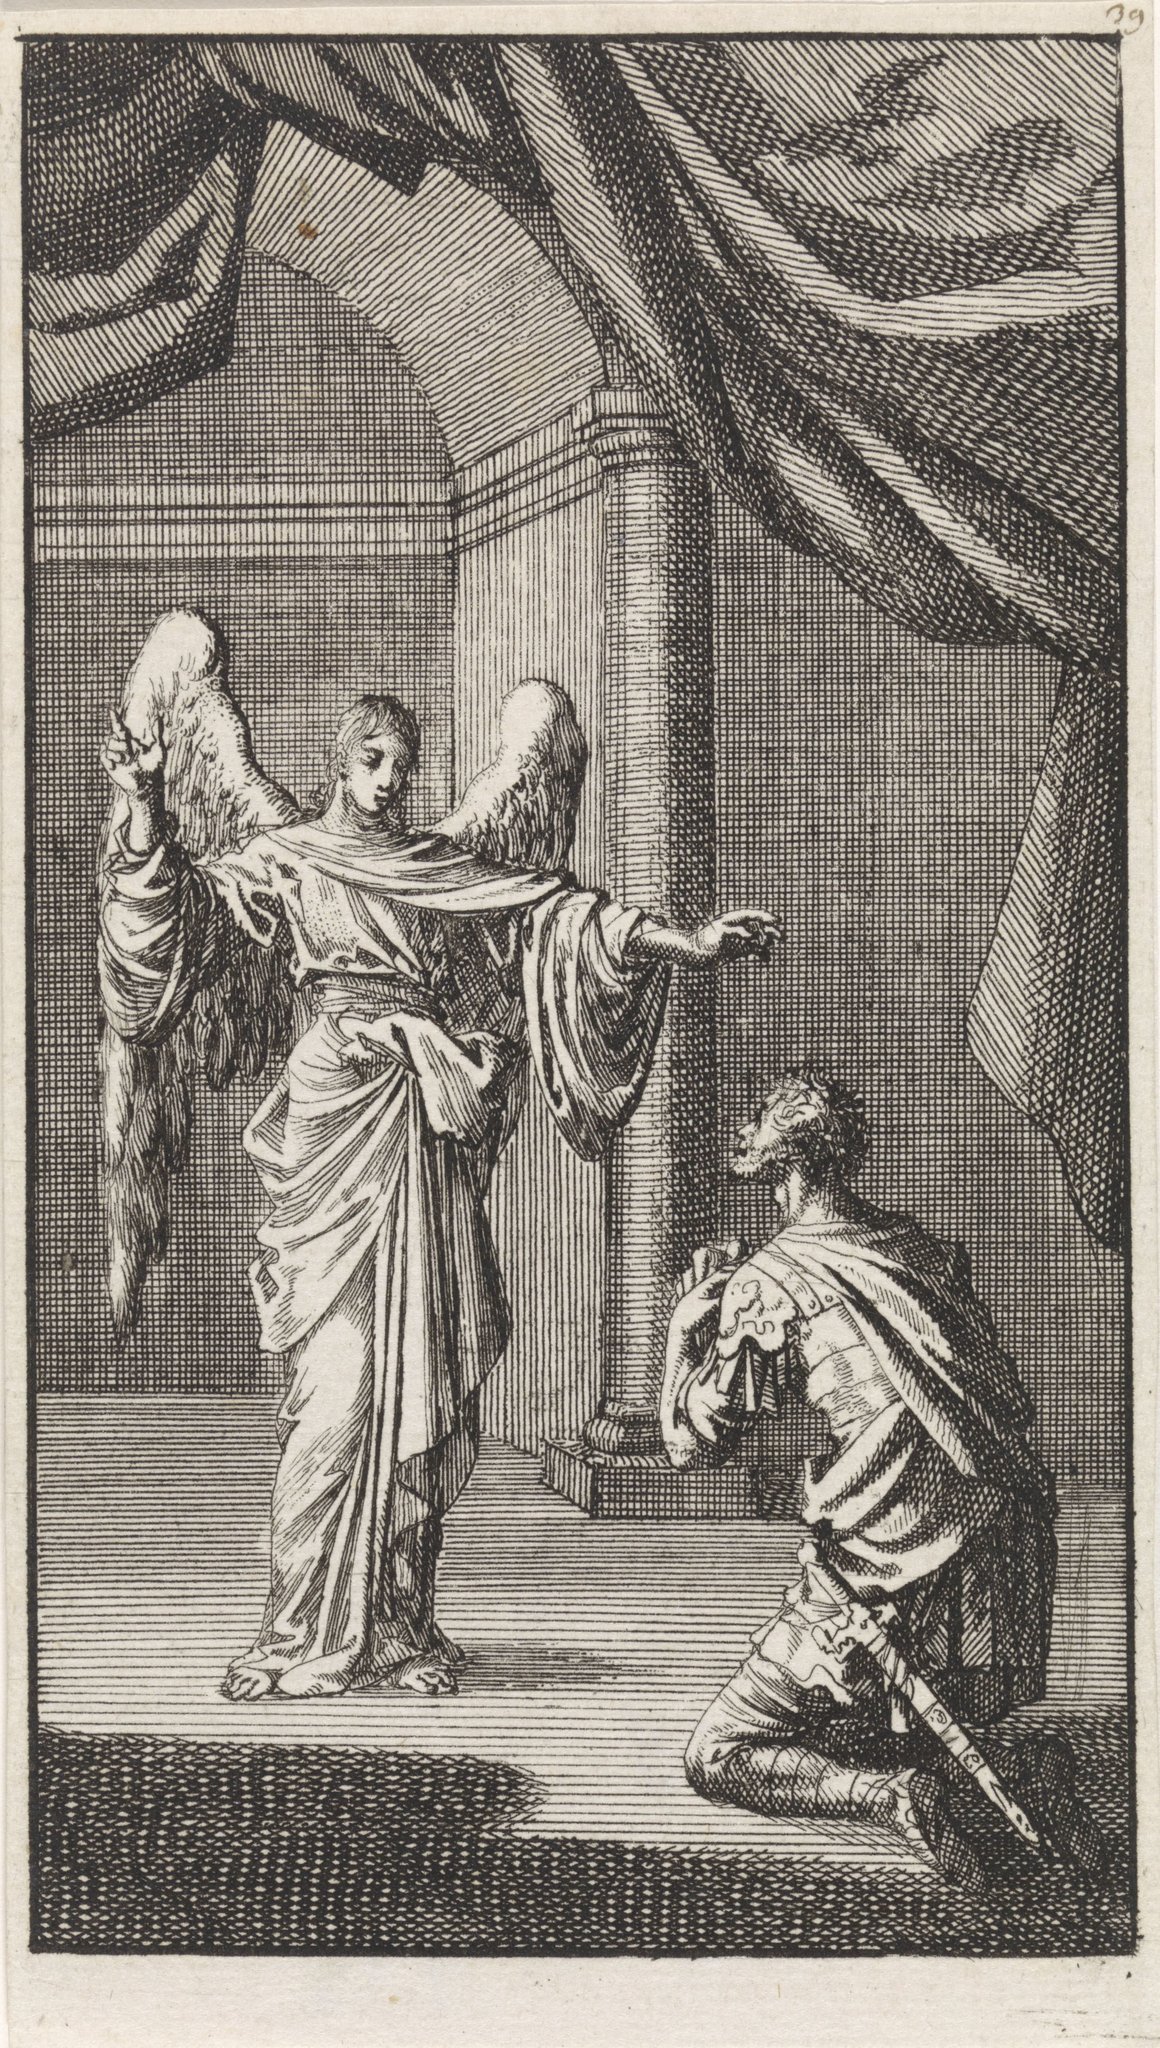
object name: print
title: Cornelius knielt voor de tot hem gezonden engel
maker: jan luyken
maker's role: draughtsman, print maker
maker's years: 1649-1712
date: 1712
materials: paper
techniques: etching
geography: amsterdam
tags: cornelius the centurion and the angel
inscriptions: collector's mark: Lugt 2228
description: Proefdruk van illustratie voor: Luyken, Jan. Bybel printen. Amsterdam: Pieter Arentsz. II (wed.) en Cornelis van der Sys, 1712, p. 39.